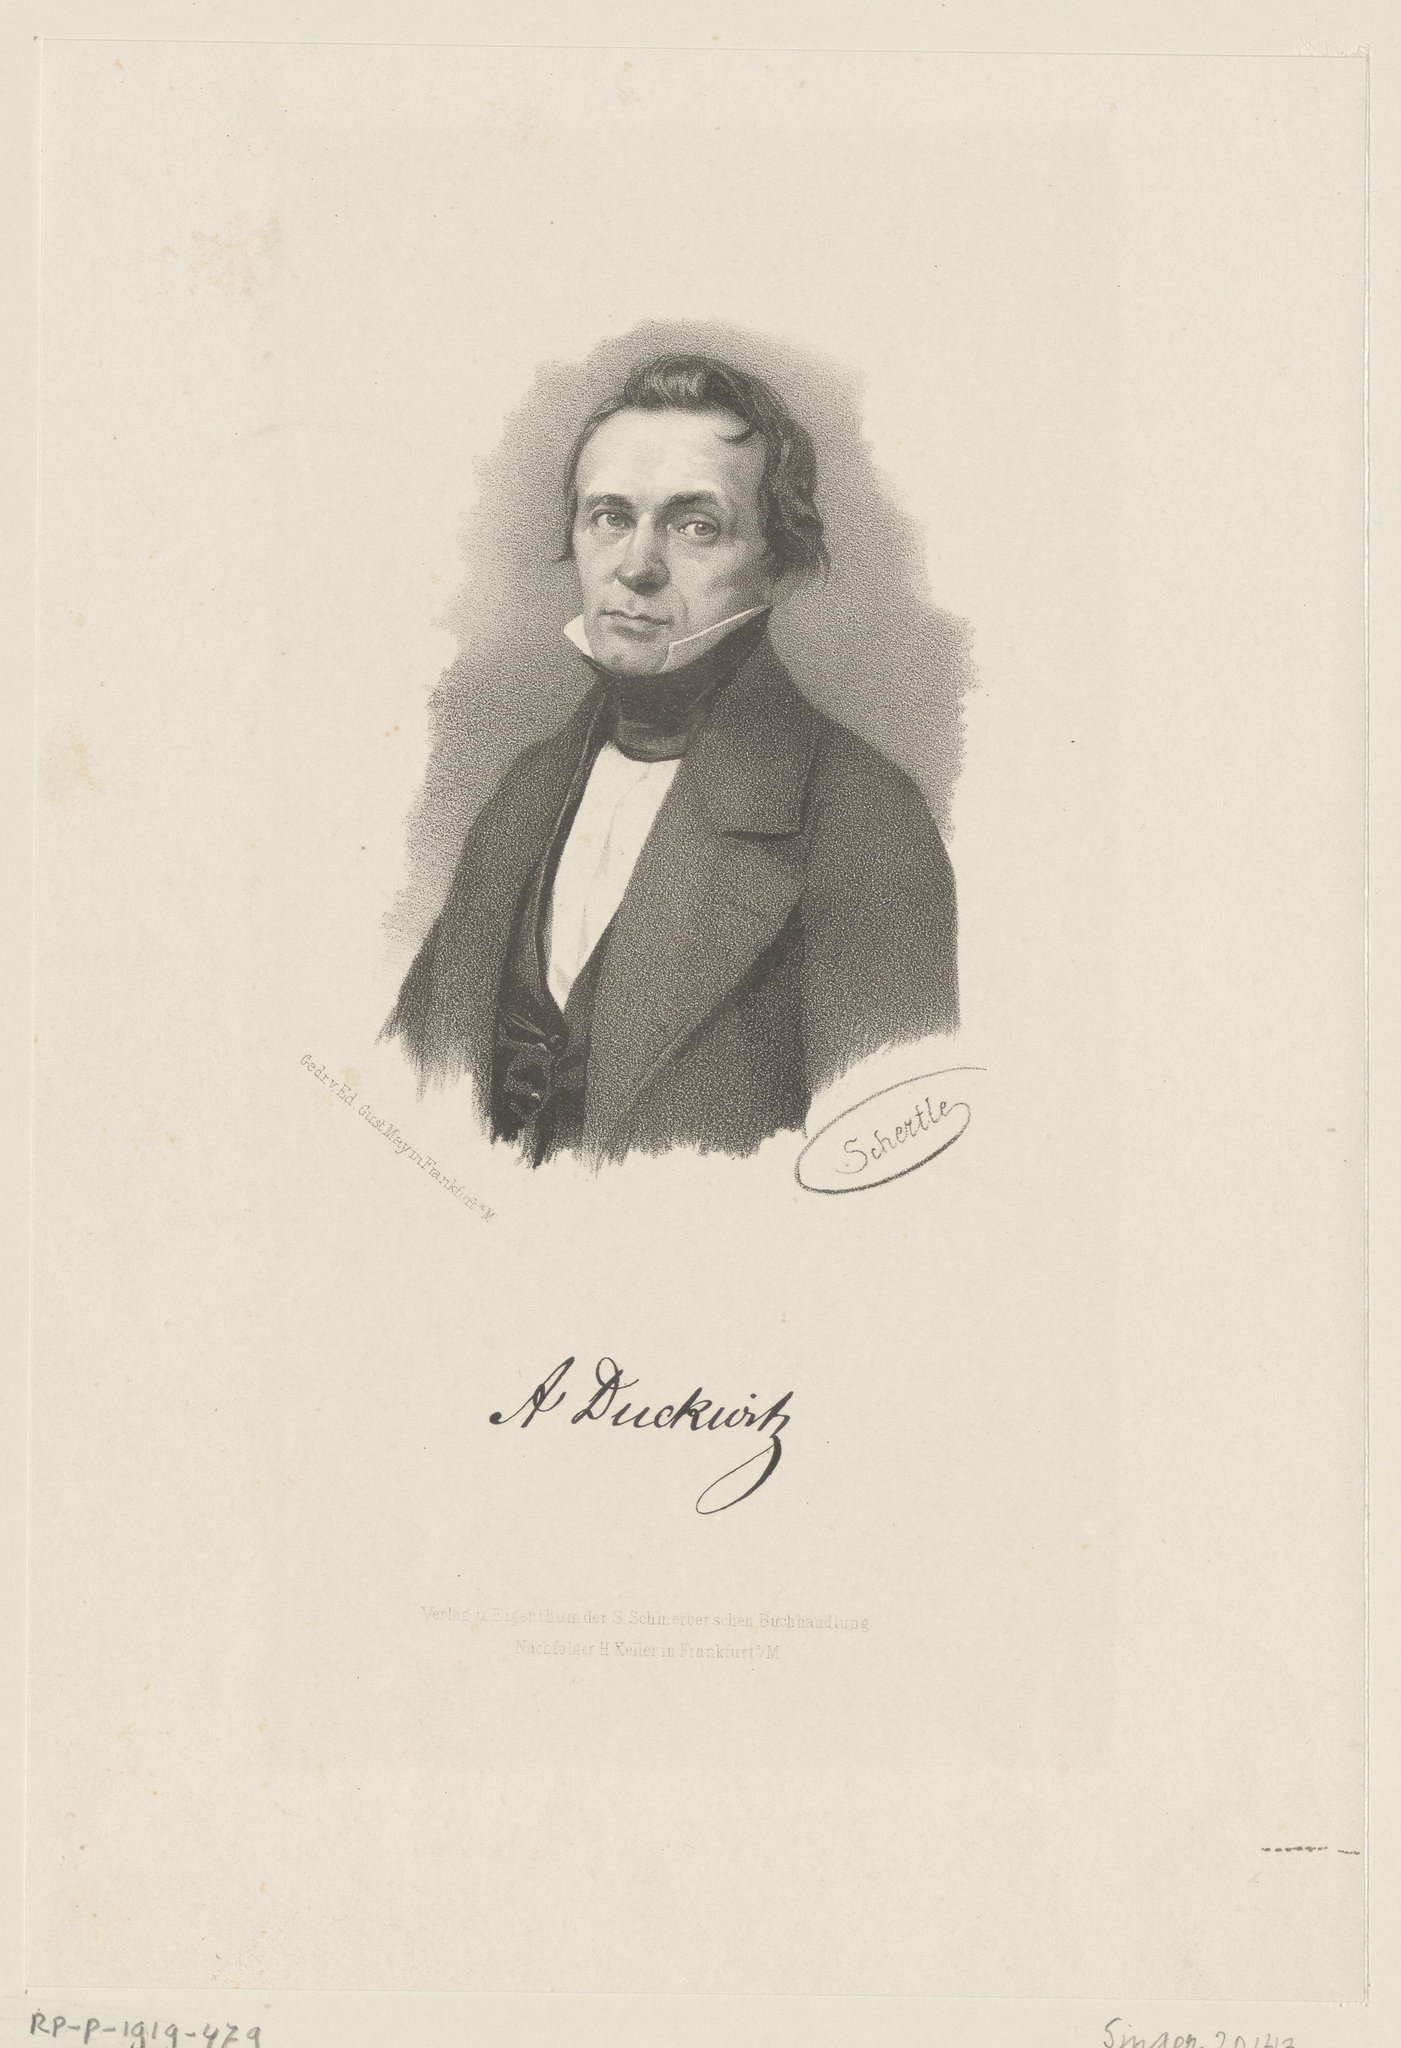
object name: print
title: Portret van Arnold Duckwitz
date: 1845-1878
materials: paper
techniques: lithograph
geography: frankfurt am main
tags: mayor, historical persons, politician, e.g. party leader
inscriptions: collector's mark: Lugt 2228